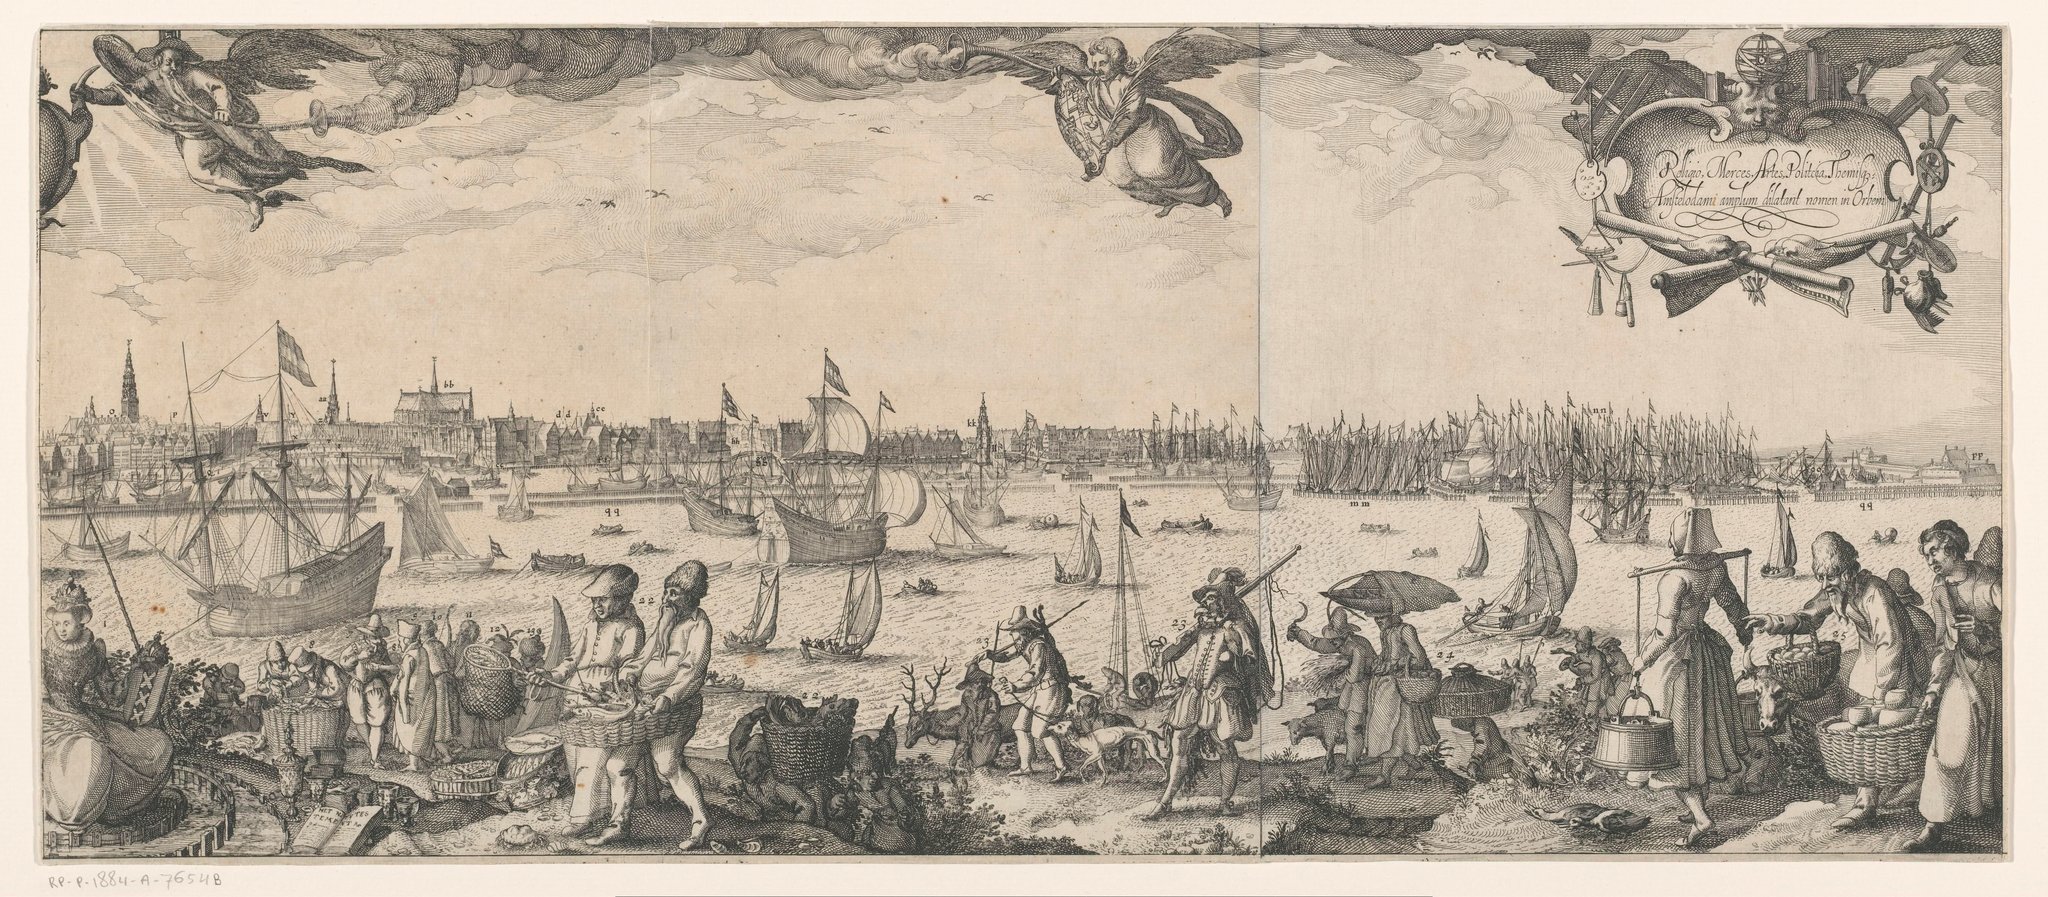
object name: print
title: Profiel van Amsterdam, gezien vanaf het IJ (rechterdeel)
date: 1611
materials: paper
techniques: engraving, etching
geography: amsterdam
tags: harbour, sailing-ship, sailing-boat, horn, trumpet, cornet, trombone, tuba - cc - out of doors, allegory of time and eternity, merchant shipping, shipping trade, prospect of city, town panorama, silhouette of city, armorial bearing, heraldry, merchant, salesman, amsterdam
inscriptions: date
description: Rechterdeel van een profiel van Amsterdam, gezien vanaf het IJ.